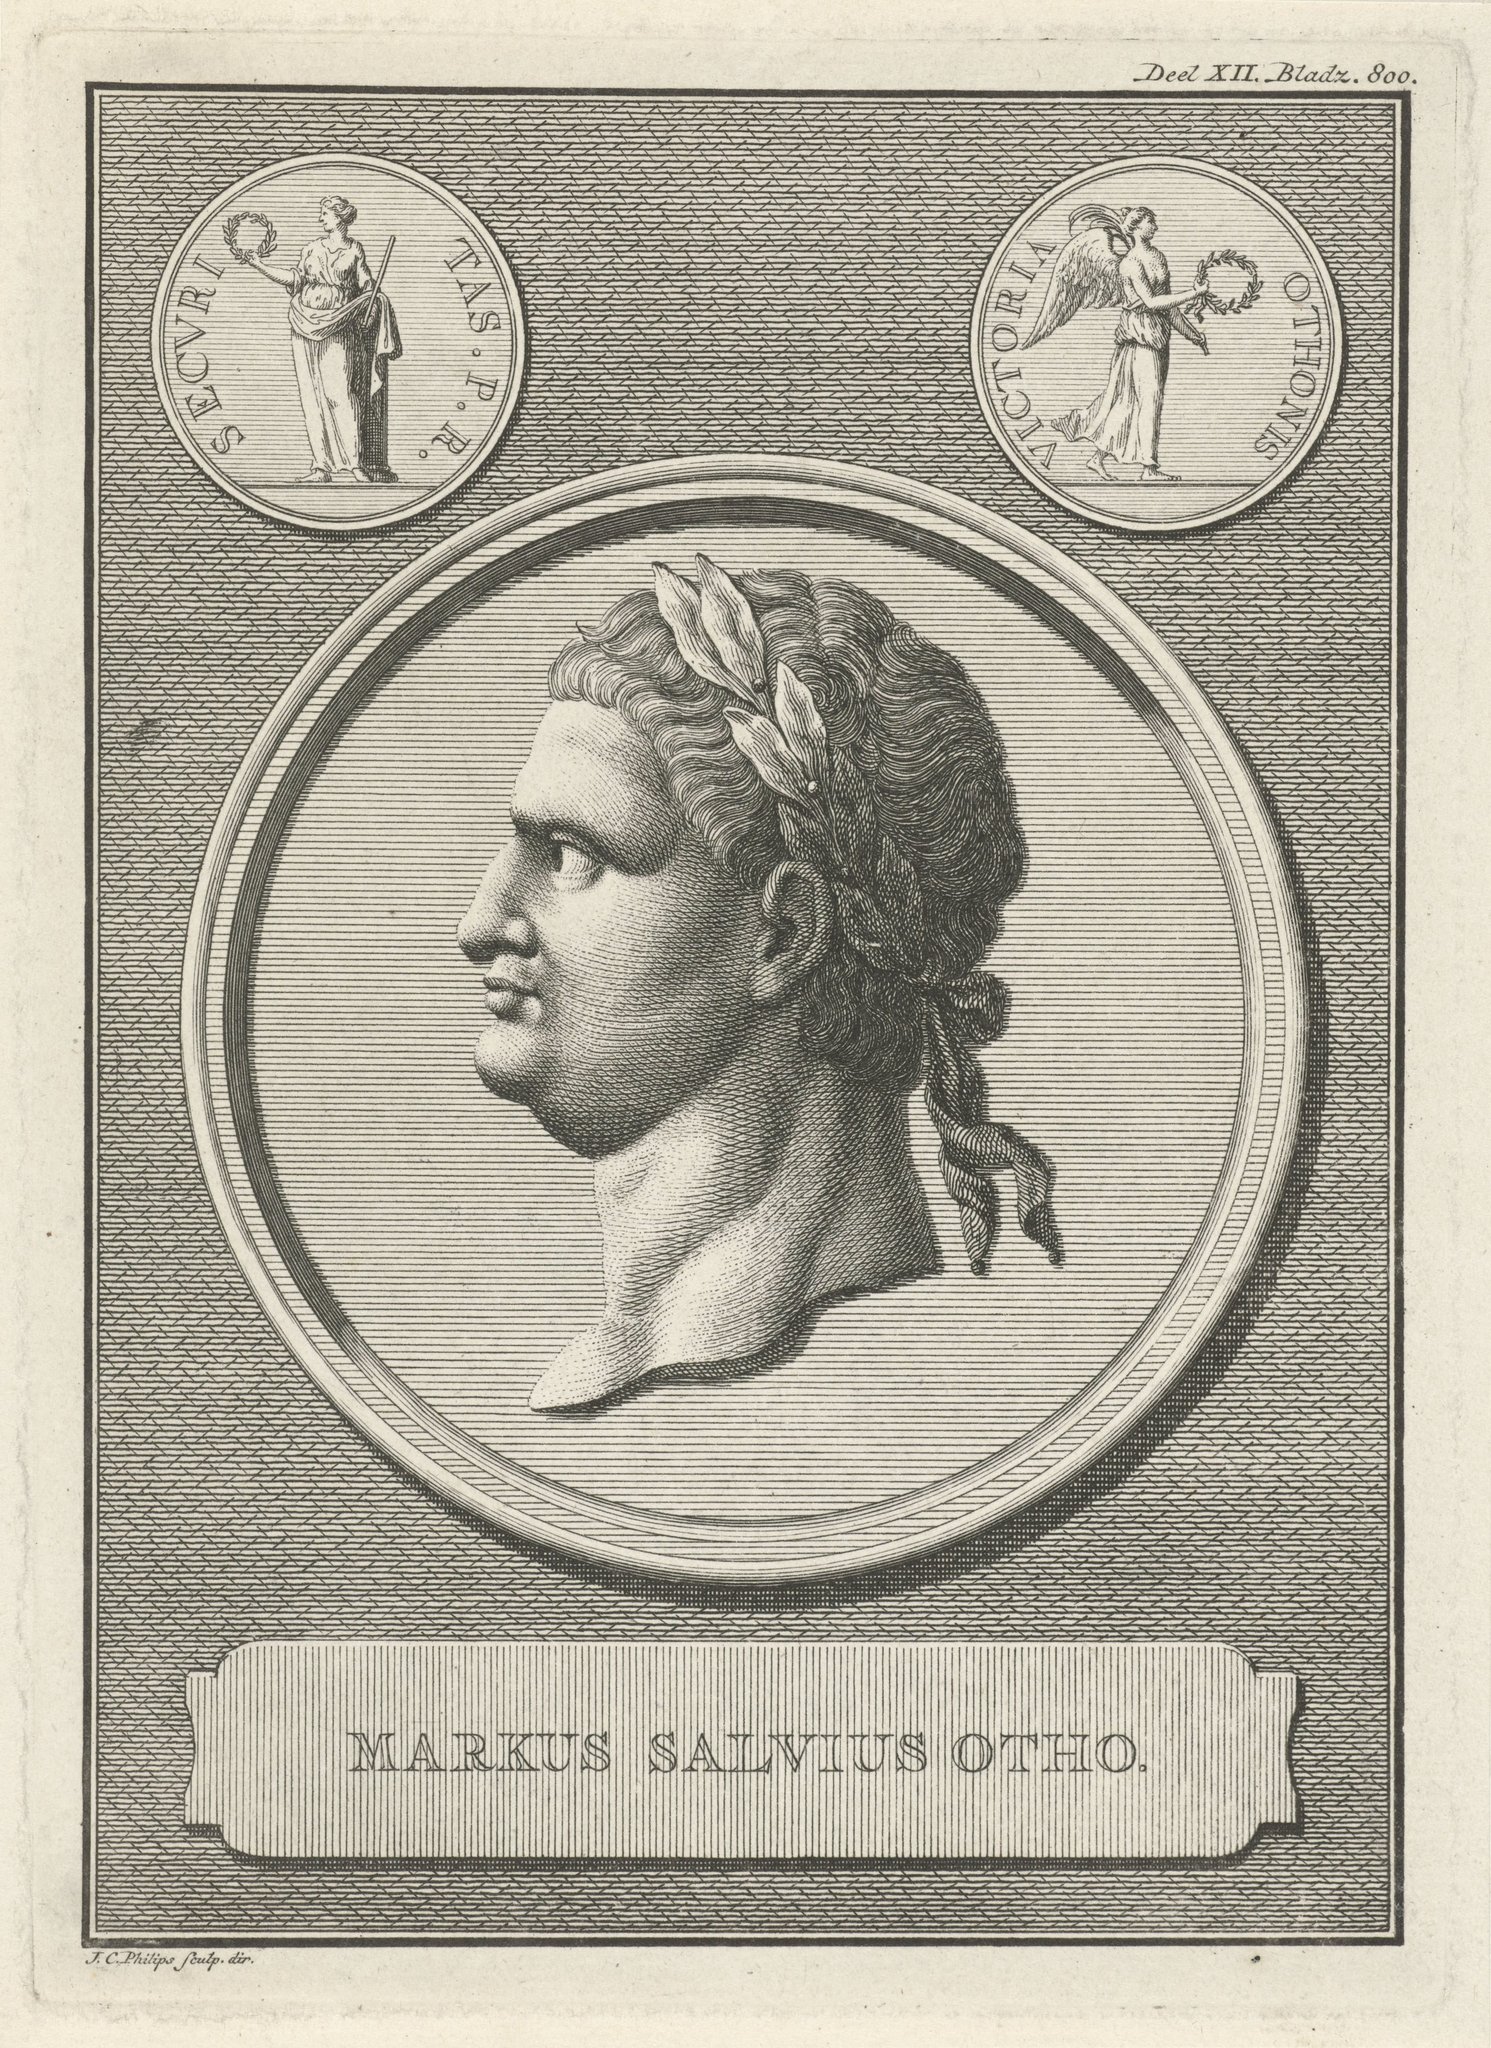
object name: book illustration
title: Portret van keizer Otho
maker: jan caspar philips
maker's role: draughtsman, print maker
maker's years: 1700-1775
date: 1746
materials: paper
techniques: engraving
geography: amsterdam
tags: coin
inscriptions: collector's mark: Lugt 2228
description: Prent gebruikt als illustratie in: Westerbaen, Kornelis, Algemeene histori van het begin der wereld af tot den tegenwoordigen tijd toe, deel XII. Utrecht: Herman Besseling, 1746.